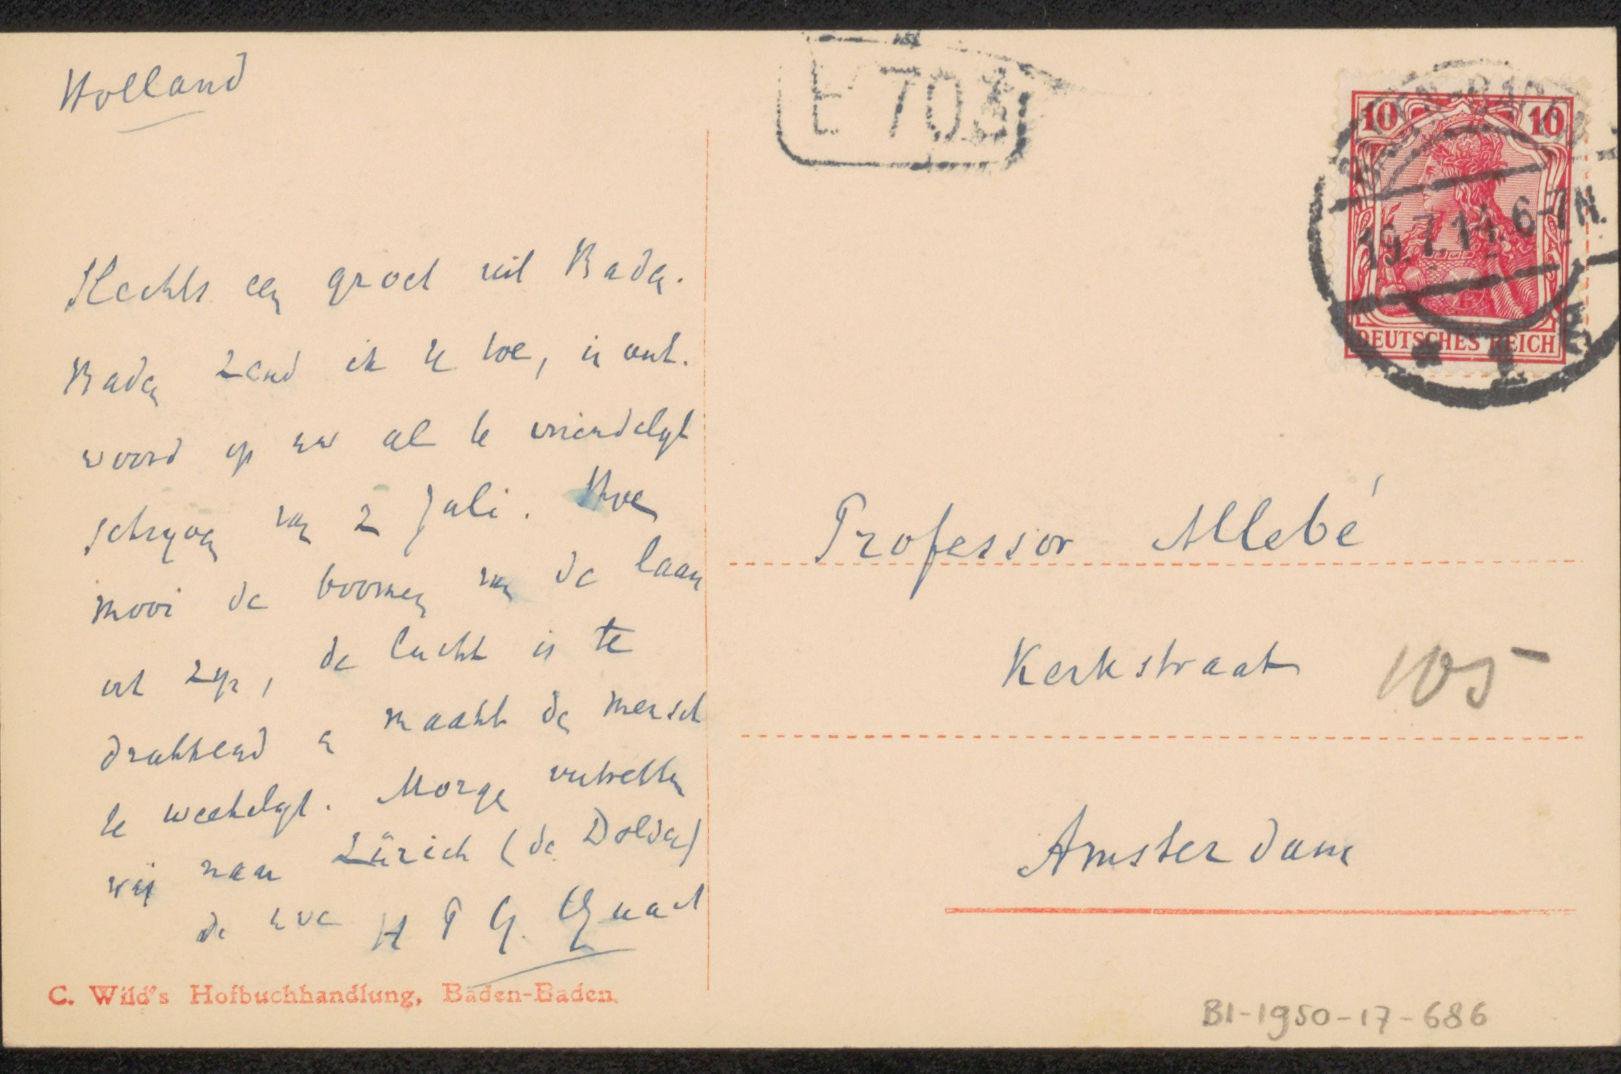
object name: ansichtkaart, prentbriefkaart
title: Prentbriefkaart aan August Allebé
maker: hendrick peter godfried quack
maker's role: econoom, geschiedschrijver, hoogleraar, jurist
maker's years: 1834-1917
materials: cardboard, ink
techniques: gelatin silver print, pen, writing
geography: baden-baden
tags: draughtsman, august allebé, travelling; tourism